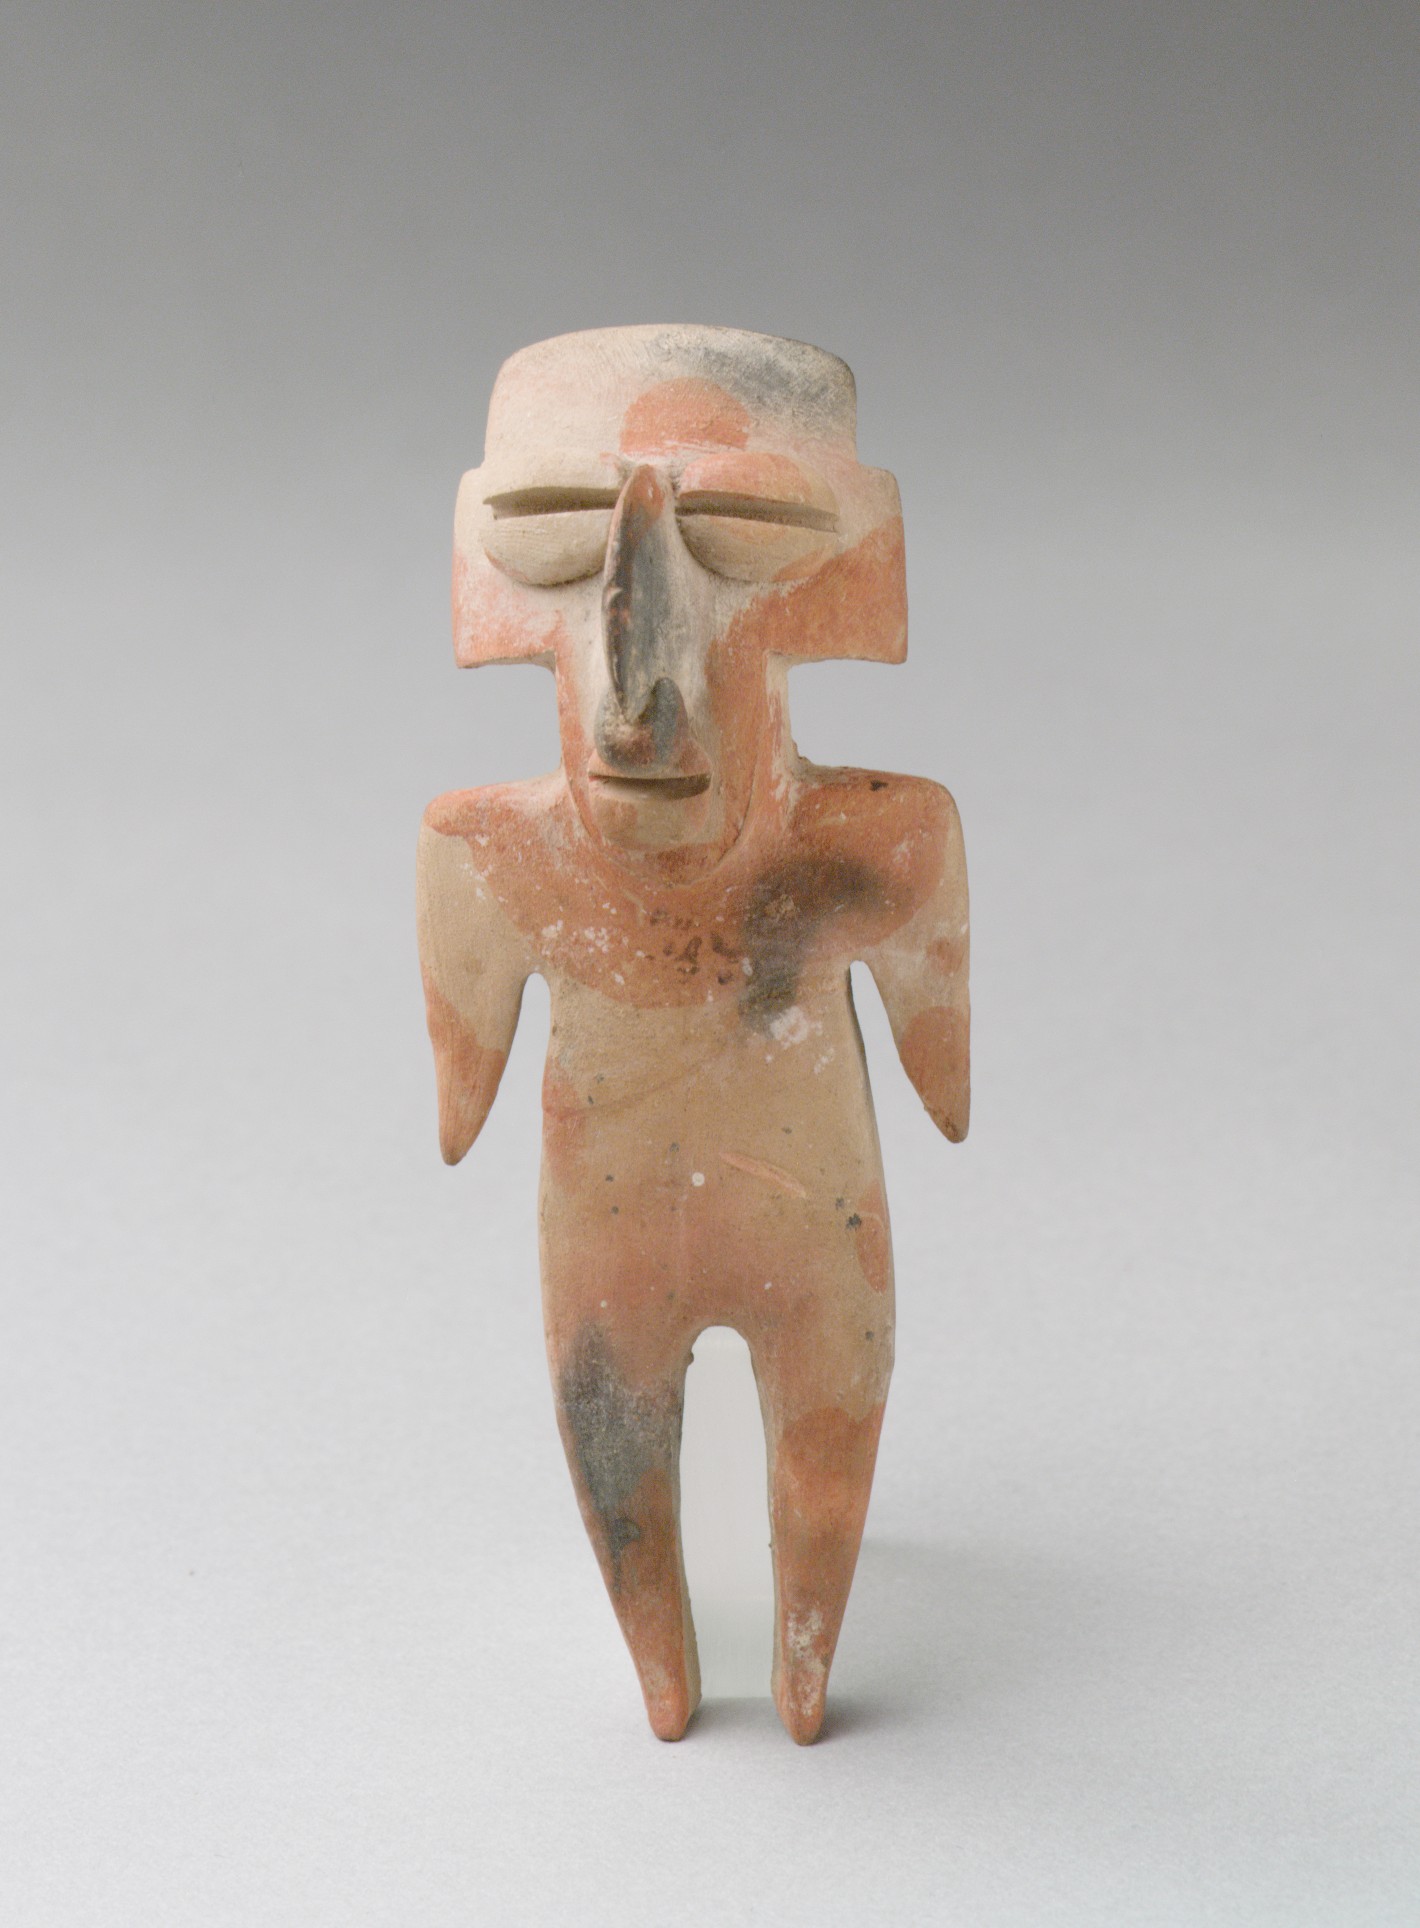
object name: figure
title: Standing Figure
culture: bahía or esteros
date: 500-1 BCE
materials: ceramic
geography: ecuador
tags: human figures